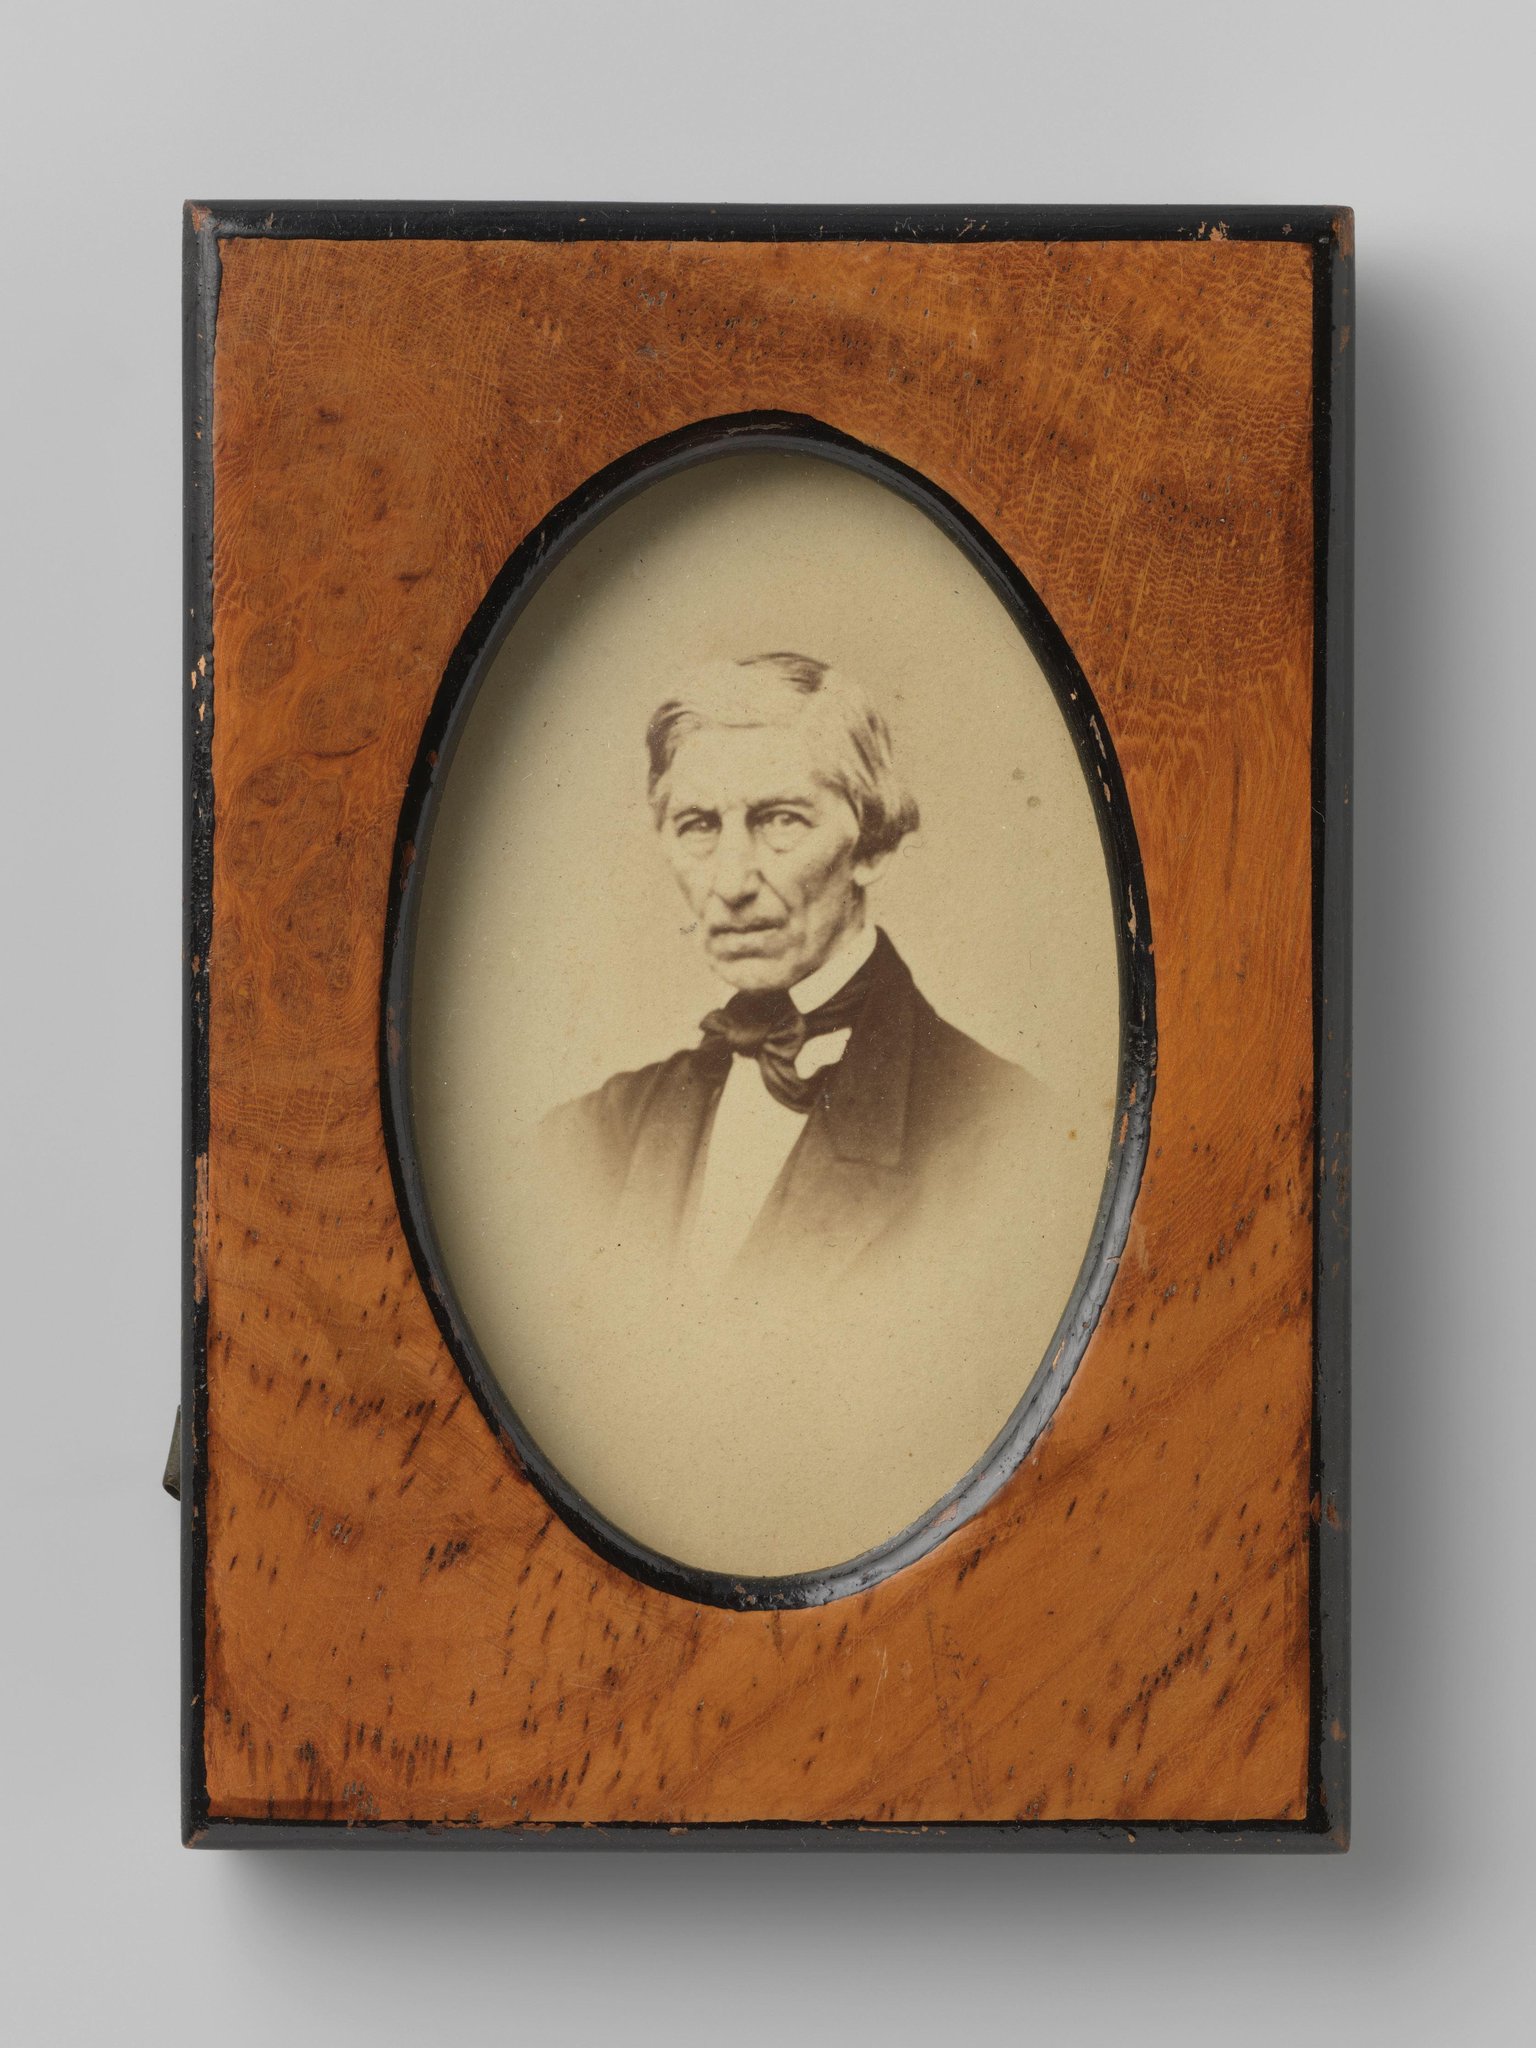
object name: frame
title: Portret van een onbekende man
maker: Anonymous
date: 1880-1900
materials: cardboard, glass, paper, textile, wood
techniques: albumen print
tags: adult man, anonymous historical person portrayed